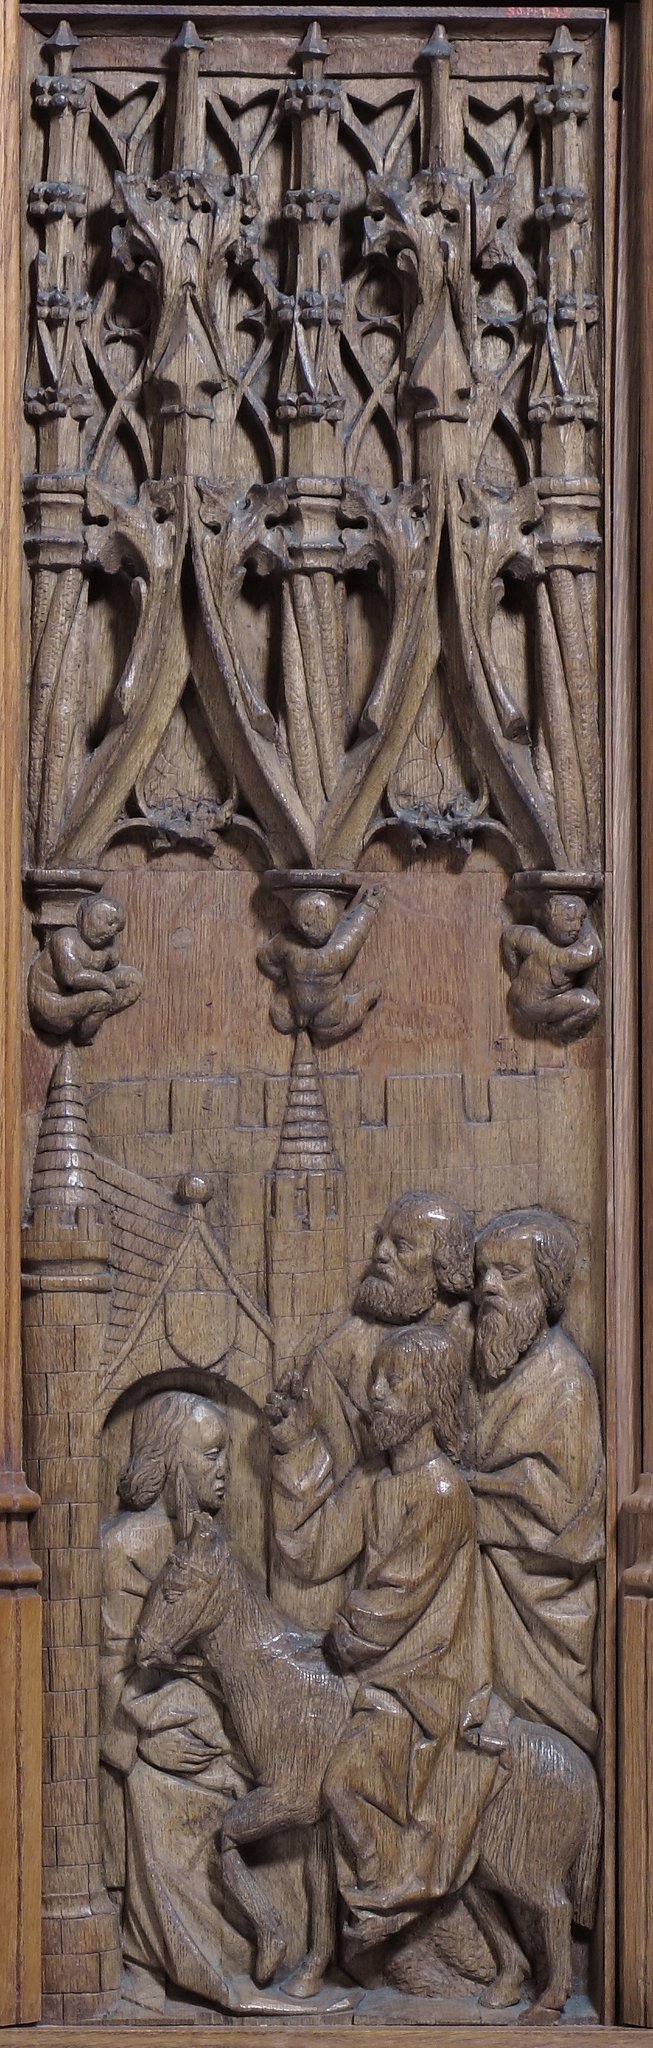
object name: panel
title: Panel with the Entry into Jerusalem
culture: french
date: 1501-1533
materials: wood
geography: france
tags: men,women,jesus